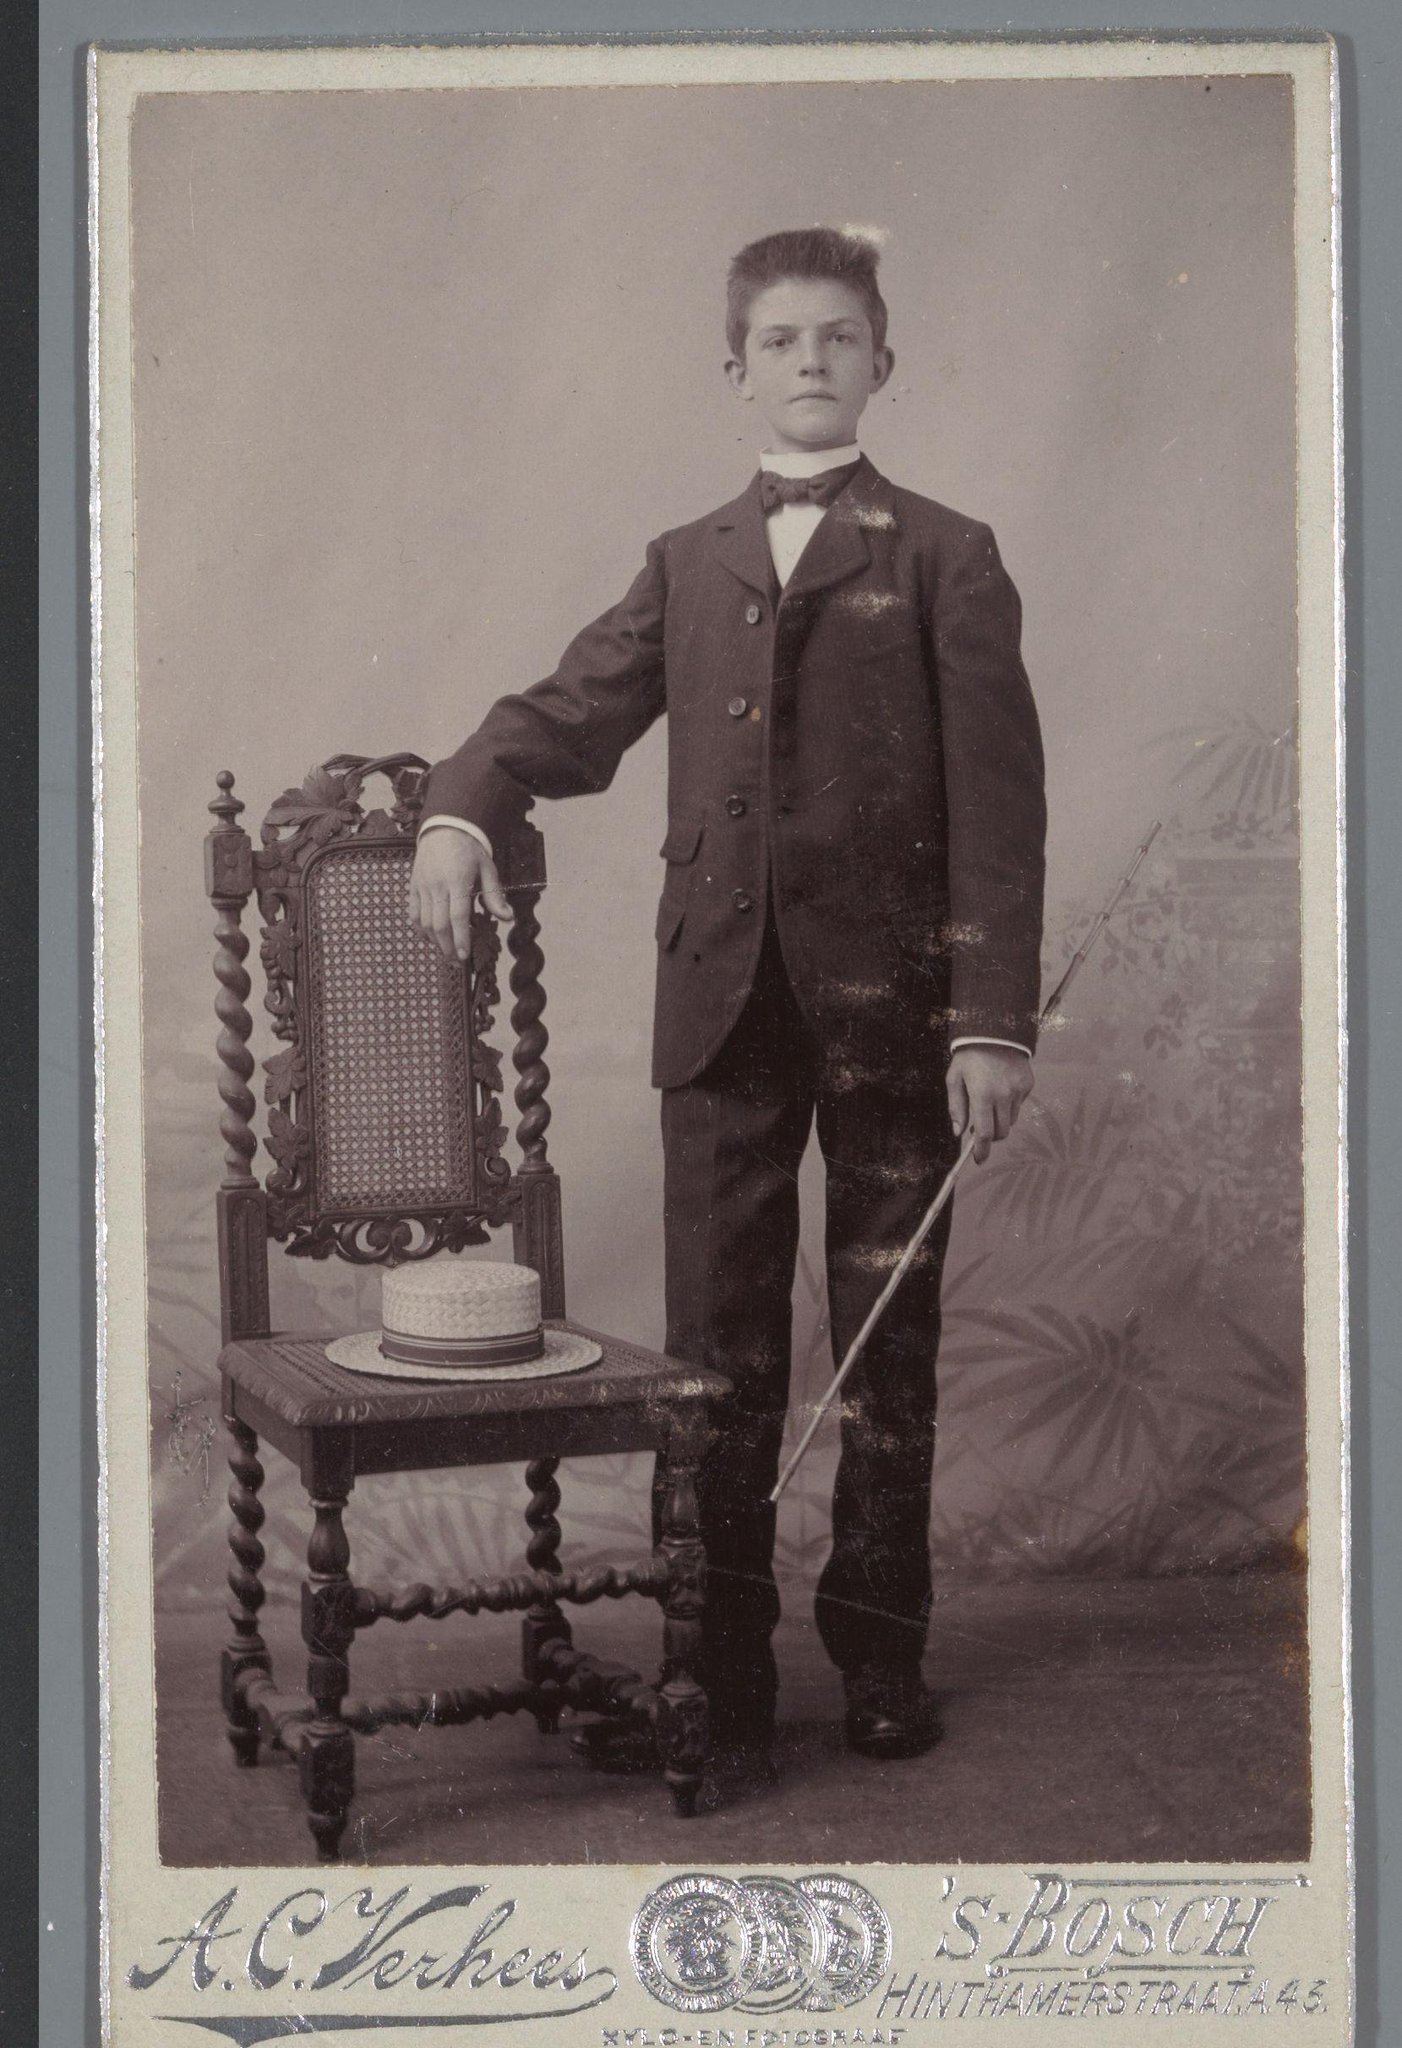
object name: photograph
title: Portret van een onbekende jongeman met stok en hoed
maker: arnoldus cornelius verhees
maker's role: print maker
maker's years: 1859-1929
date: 1874-1929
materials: paper, cardboard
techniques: collodion silver print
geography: den bosch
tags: youth, adolescent, anonymous historical person portrayed, den bosch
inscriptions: inscription: ‘A.C. Verhees/ 's-Bosch/ Hinthamerstraat A.43./ Xylo-en fotograaf’